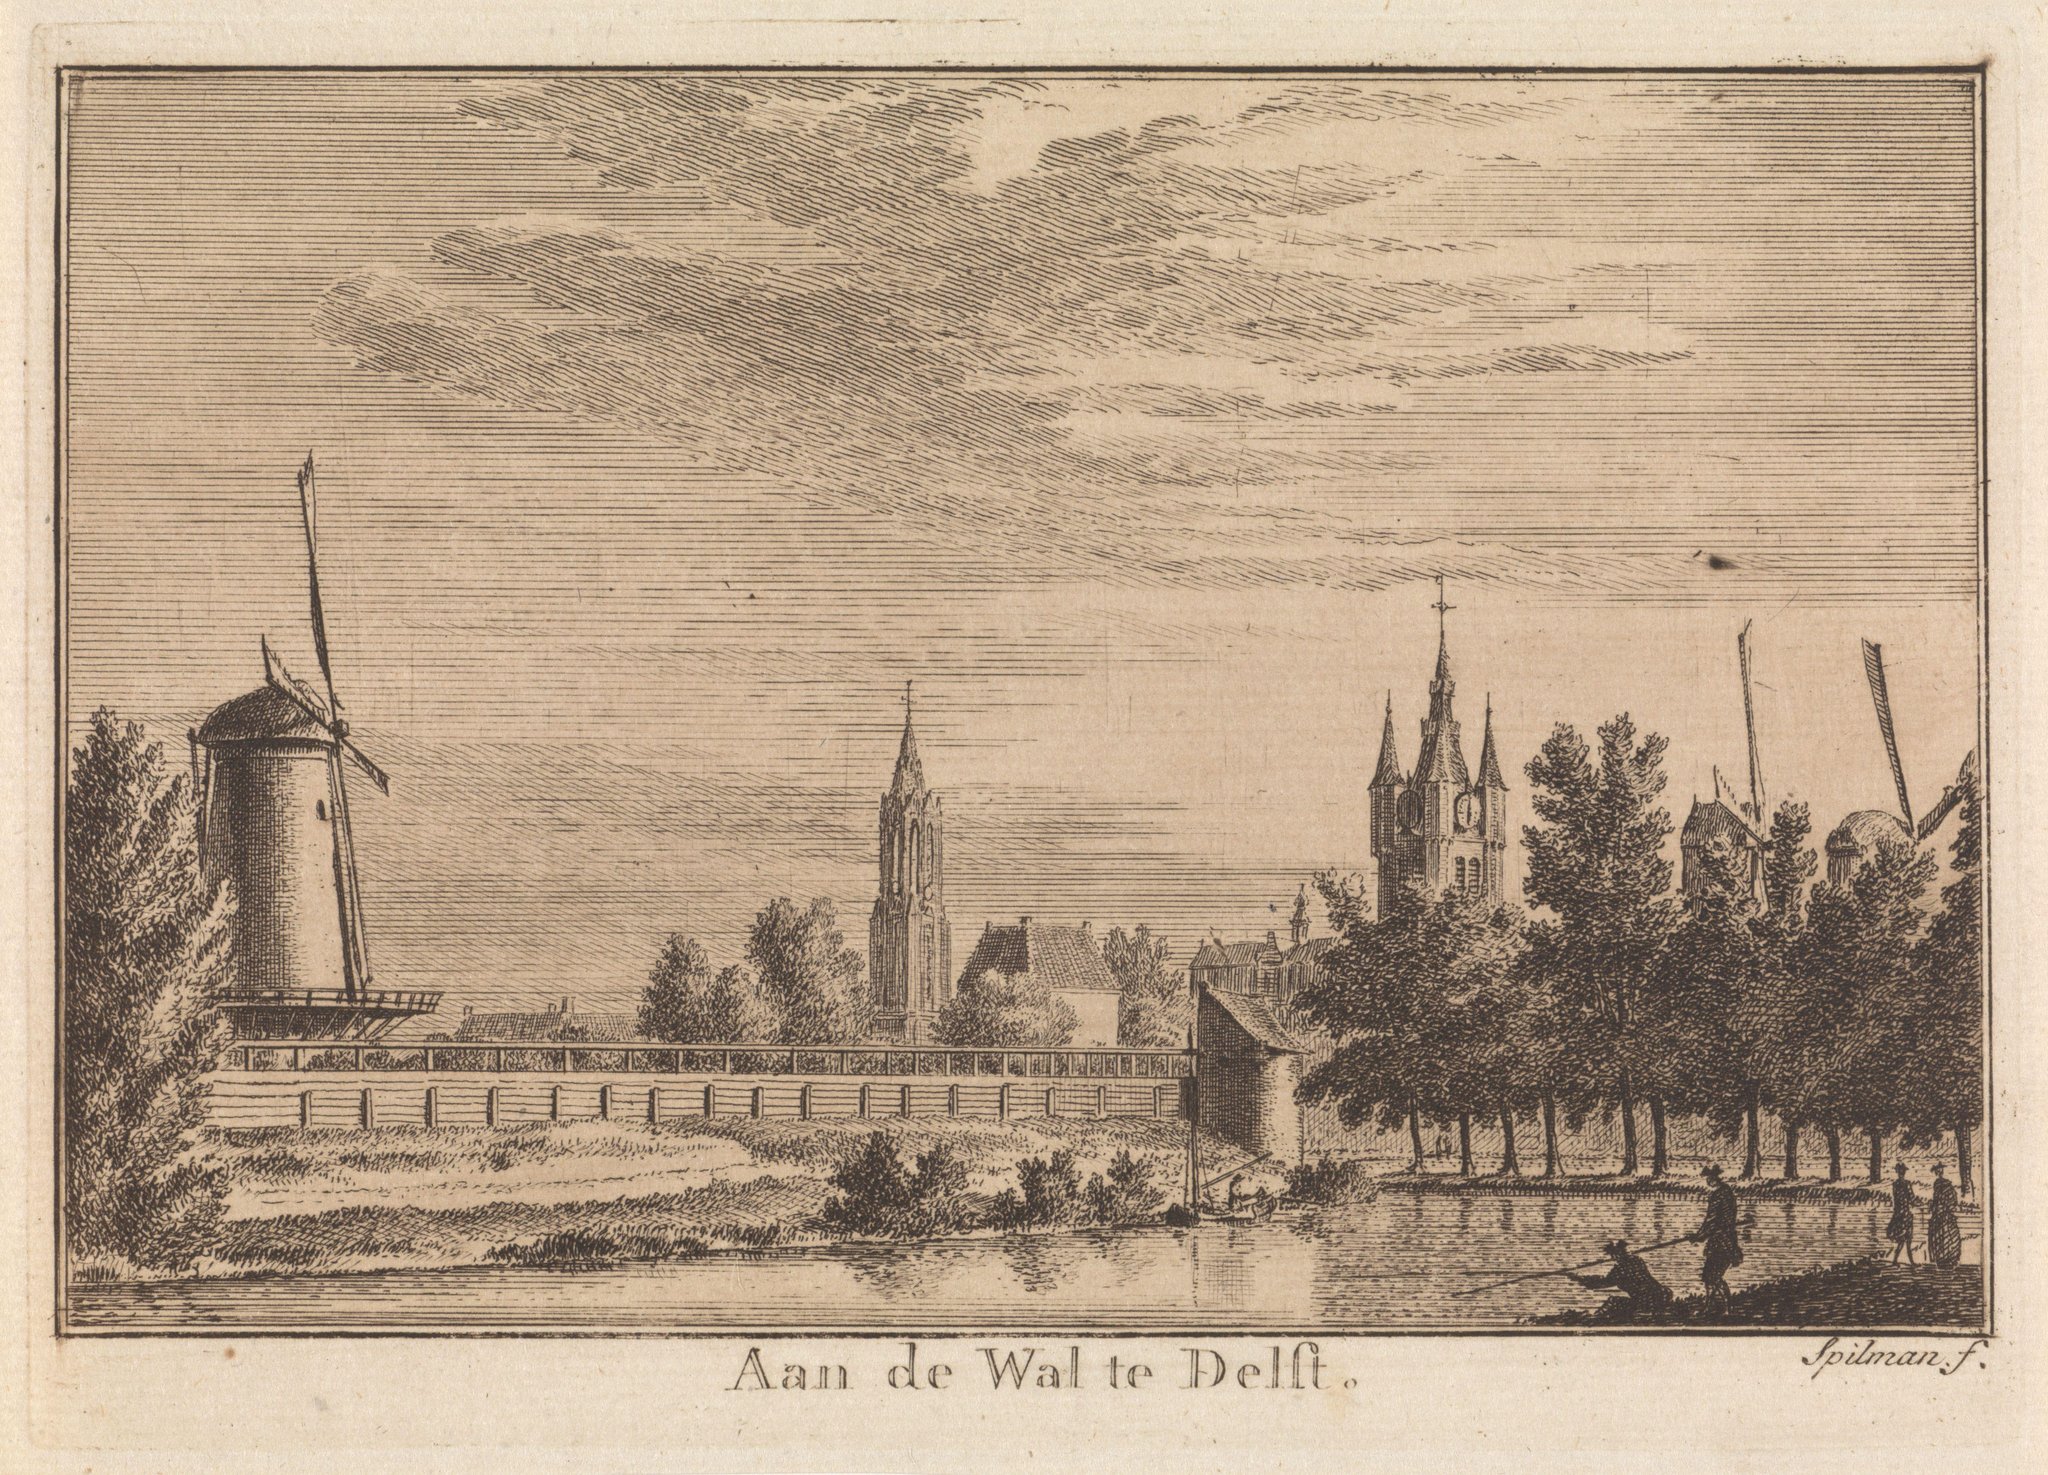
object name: print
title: Gezicht op Delft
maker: hendrik spilman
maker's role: draughtsman, painter, print maker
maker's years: 1721-1784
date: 1742-1784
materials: paper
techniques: etching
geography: haarlem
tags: church (exterior), outskirts of city, windmill in landscape (+ city(-scape) with figures, staffage), delft